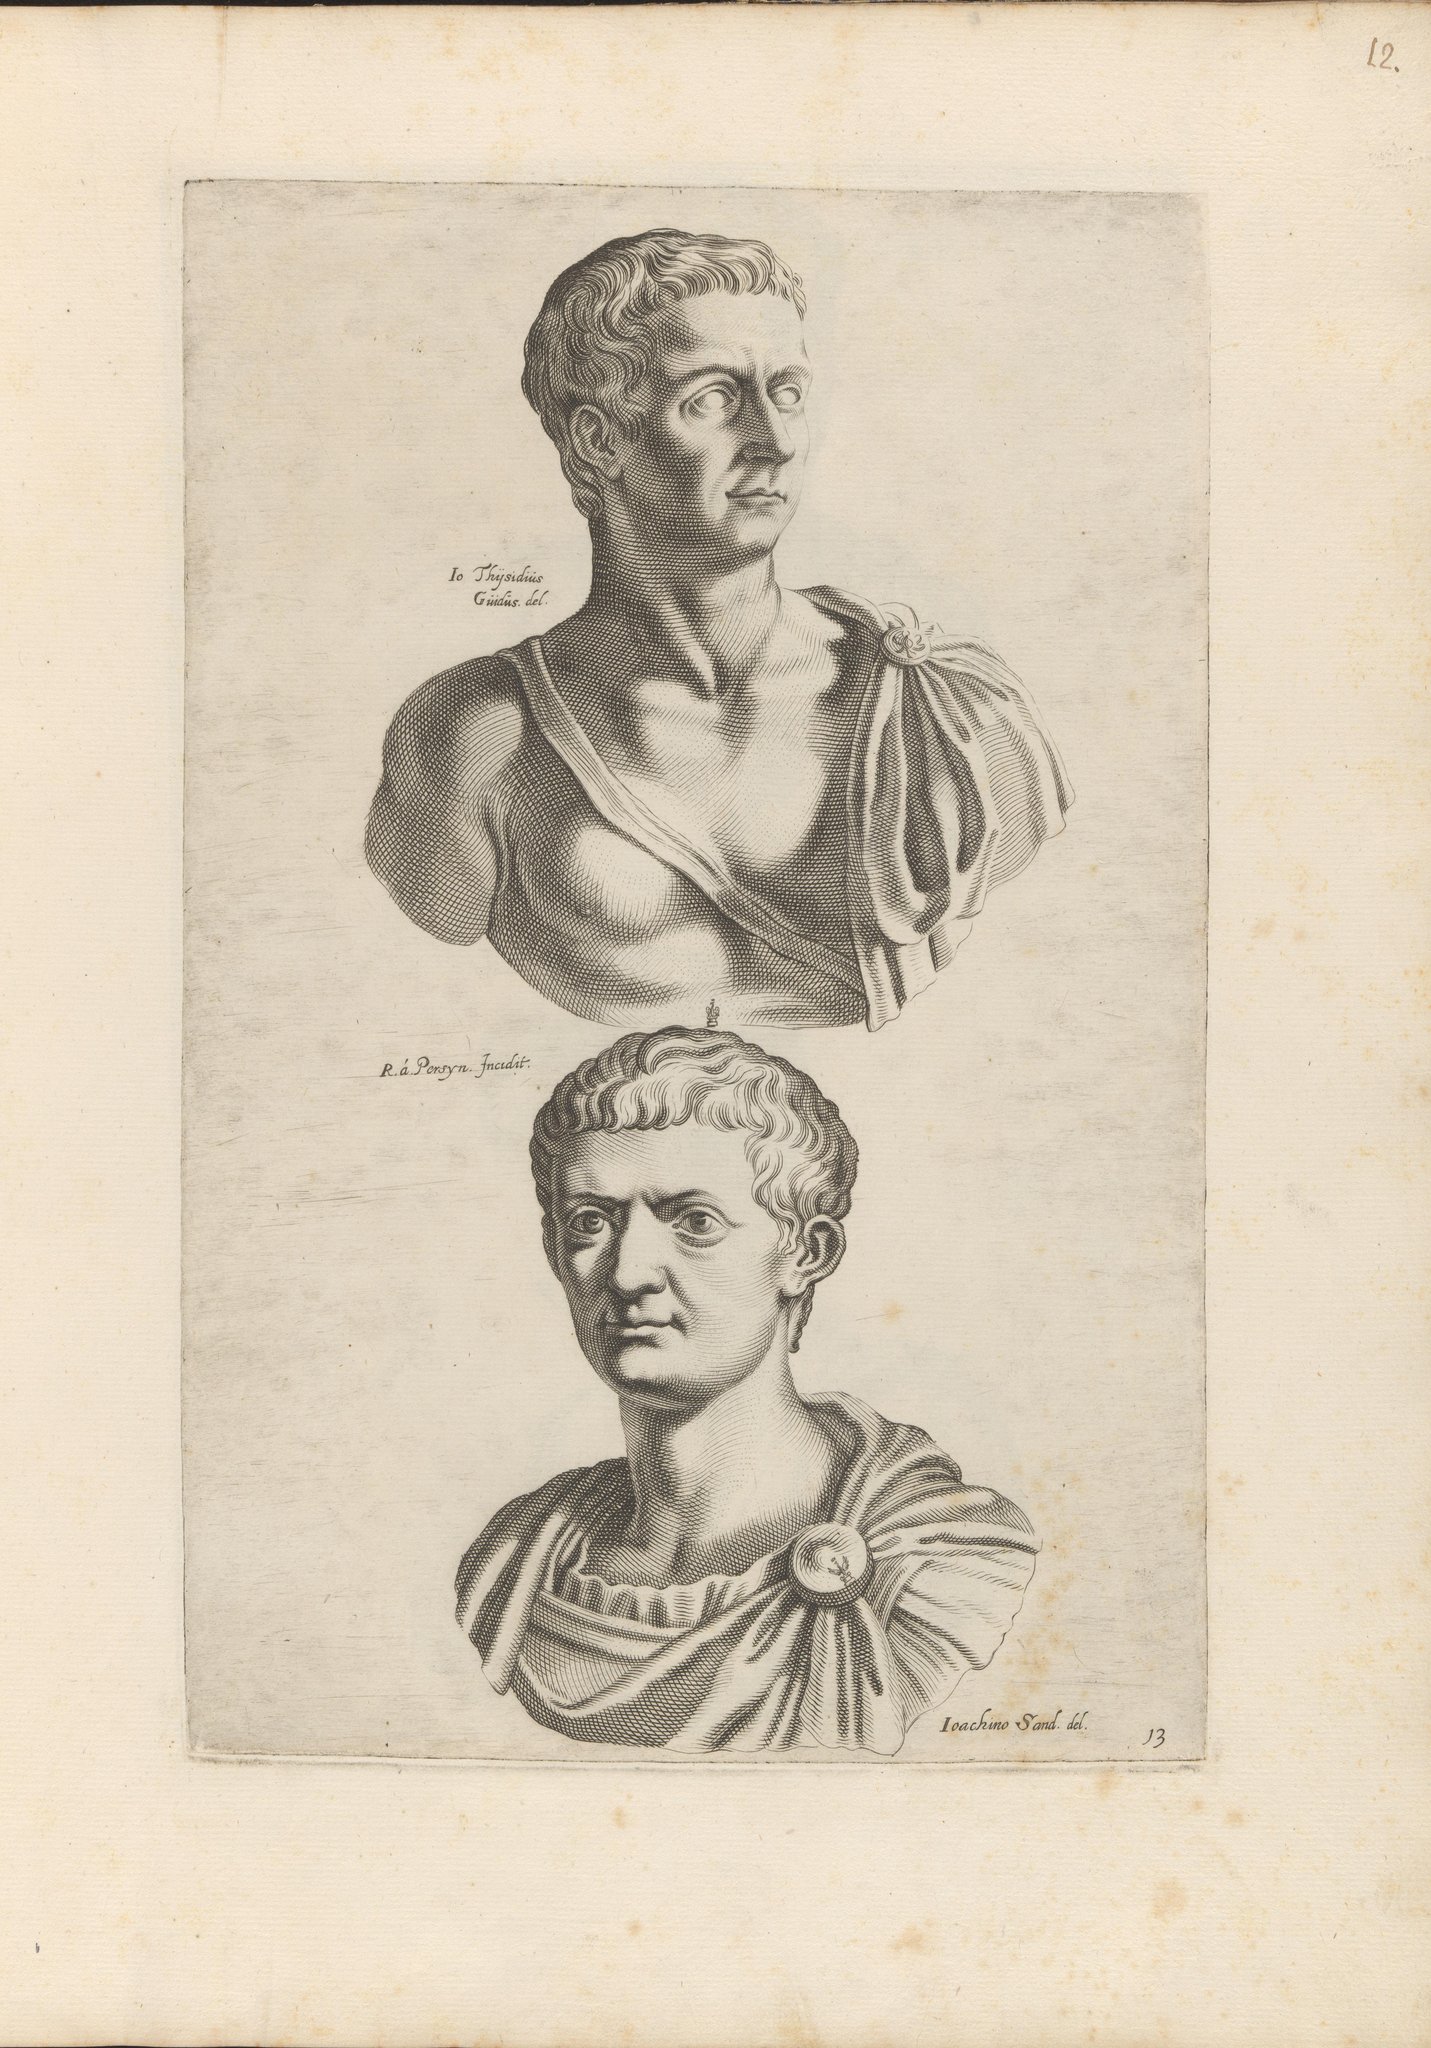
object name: print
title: Twee portretbustes van keizer Tiberius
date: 1636-1647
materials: paper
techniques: engraving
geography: rome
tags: miseno, male persons from classical history (+ head, bust, etc.), piece of sculpture, reproduction of a piece of sculpture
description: Twee Romeinse portretbustes van keizer Tiberius, in toga. Op de bustes het wapenschild van Vincenzo Giustiniani. Prent maakt deel uit van een album met een serie prenten naar de sculpturen in de verzameling in de Galleria Giustiniani te Rome.